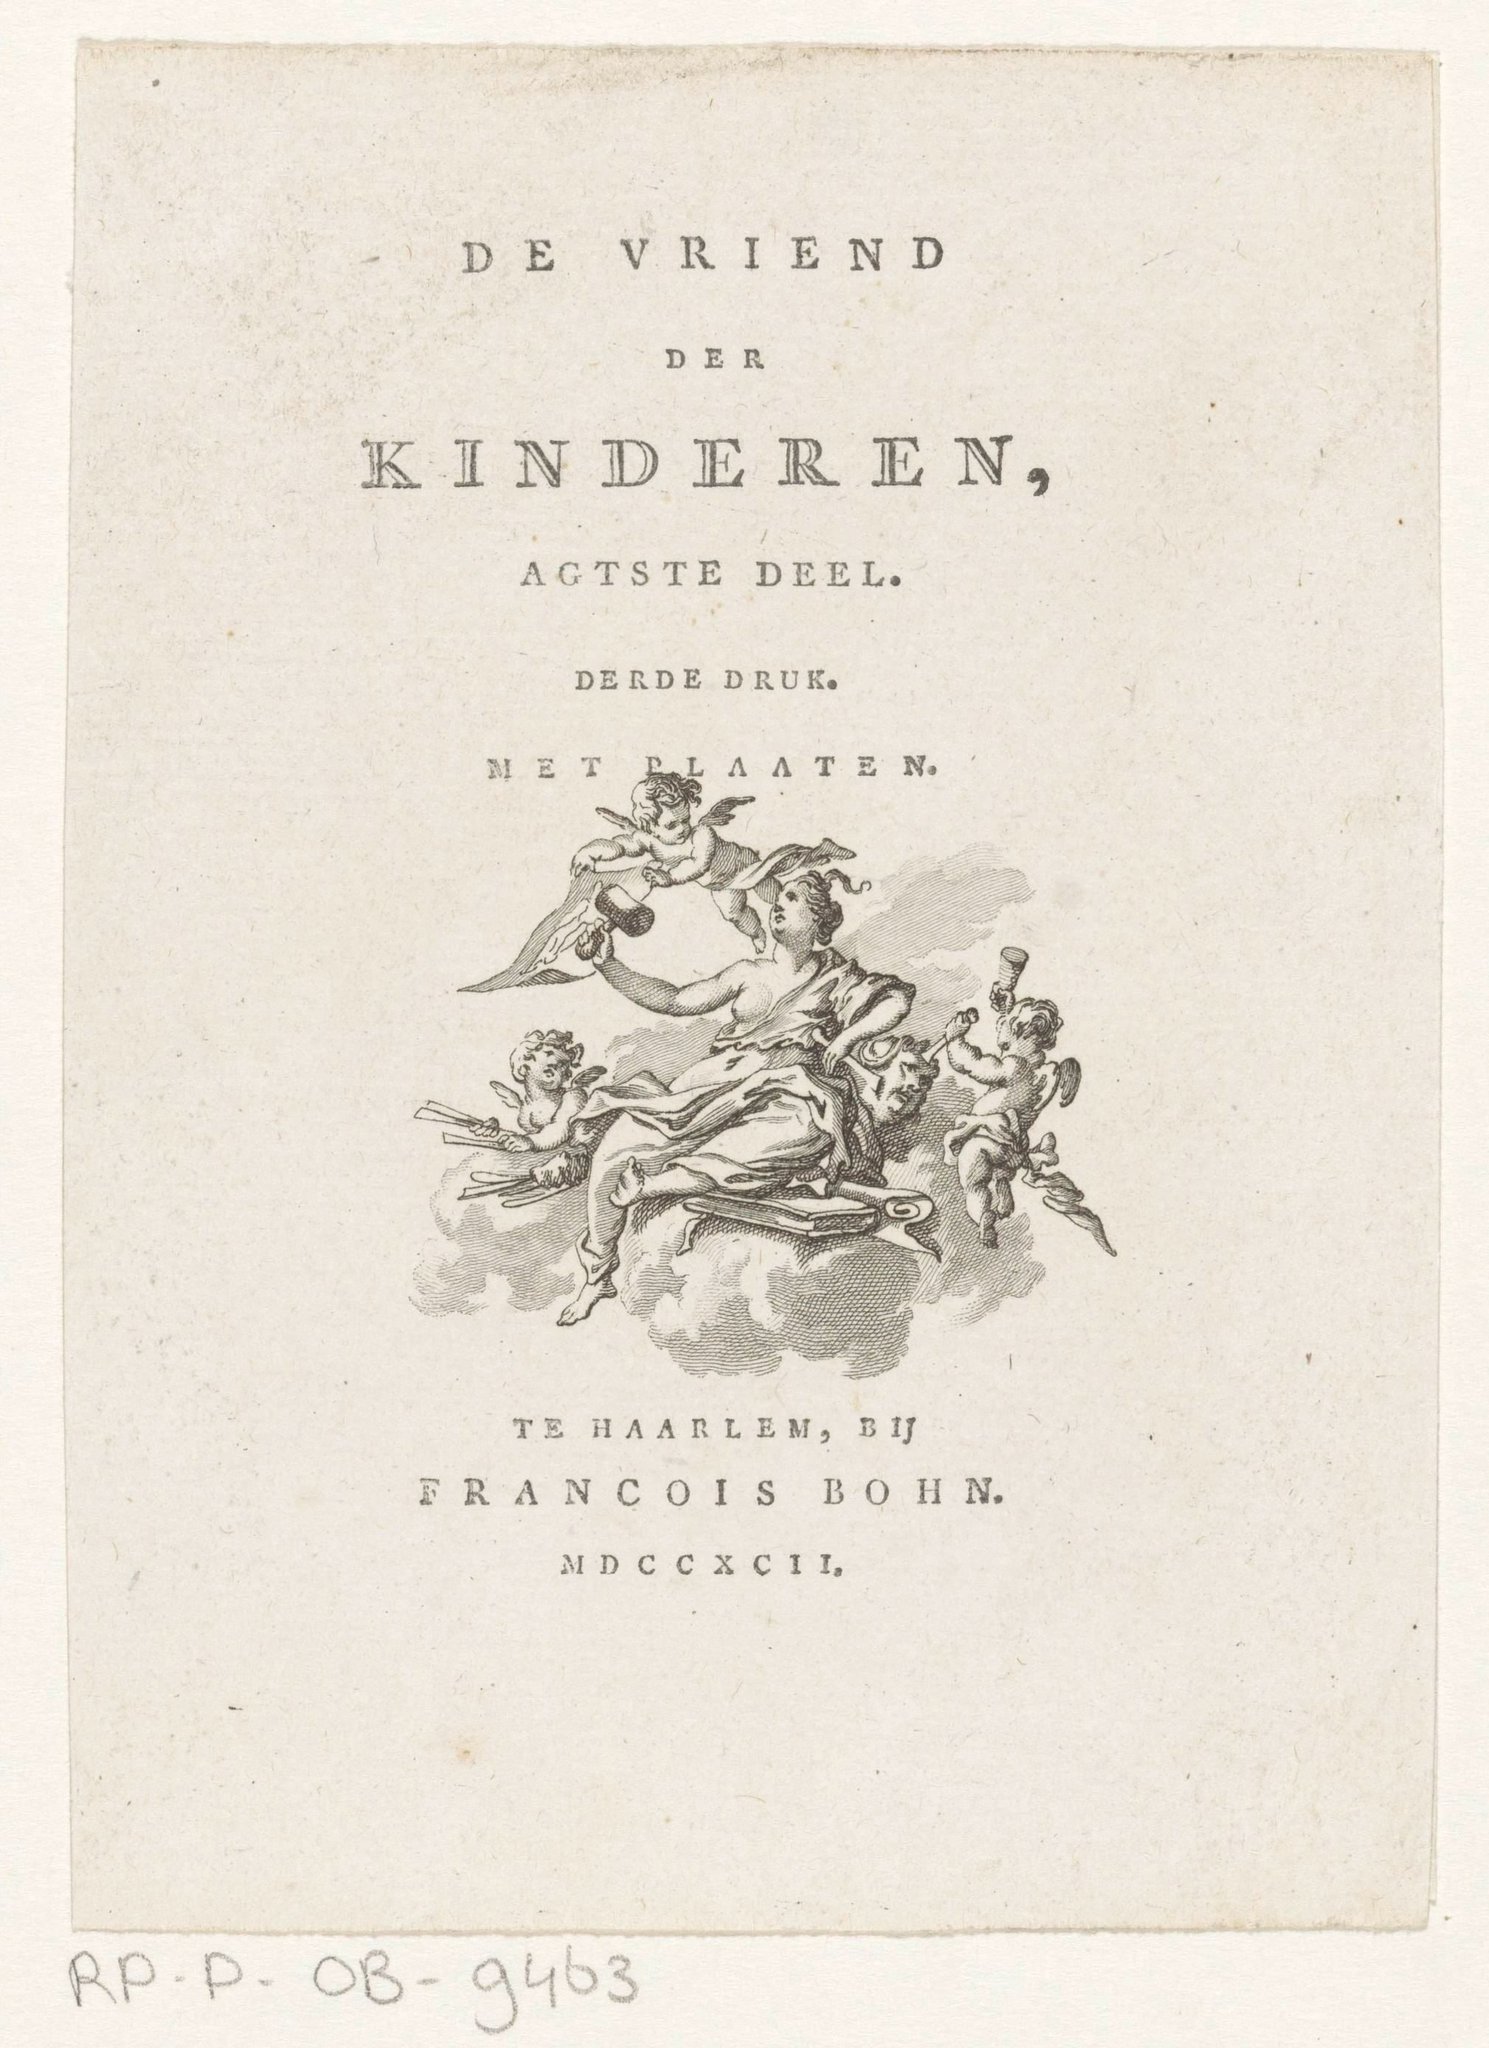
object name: print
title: Titelpagina voor: S.n. De vriend der kinderen, 1792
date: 1792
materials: paper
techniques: engraving, etching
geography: haarlem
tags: 'sculptura', symbolic representations, allegories and emblems ~ sculpture; 'scoltura' (ripa)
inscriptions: collector's mark: Lugt 2228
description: Titelpagina voor: S.n. De vriend der kinderen, agtste deel. Haarlem: Bohn, François, 1792.